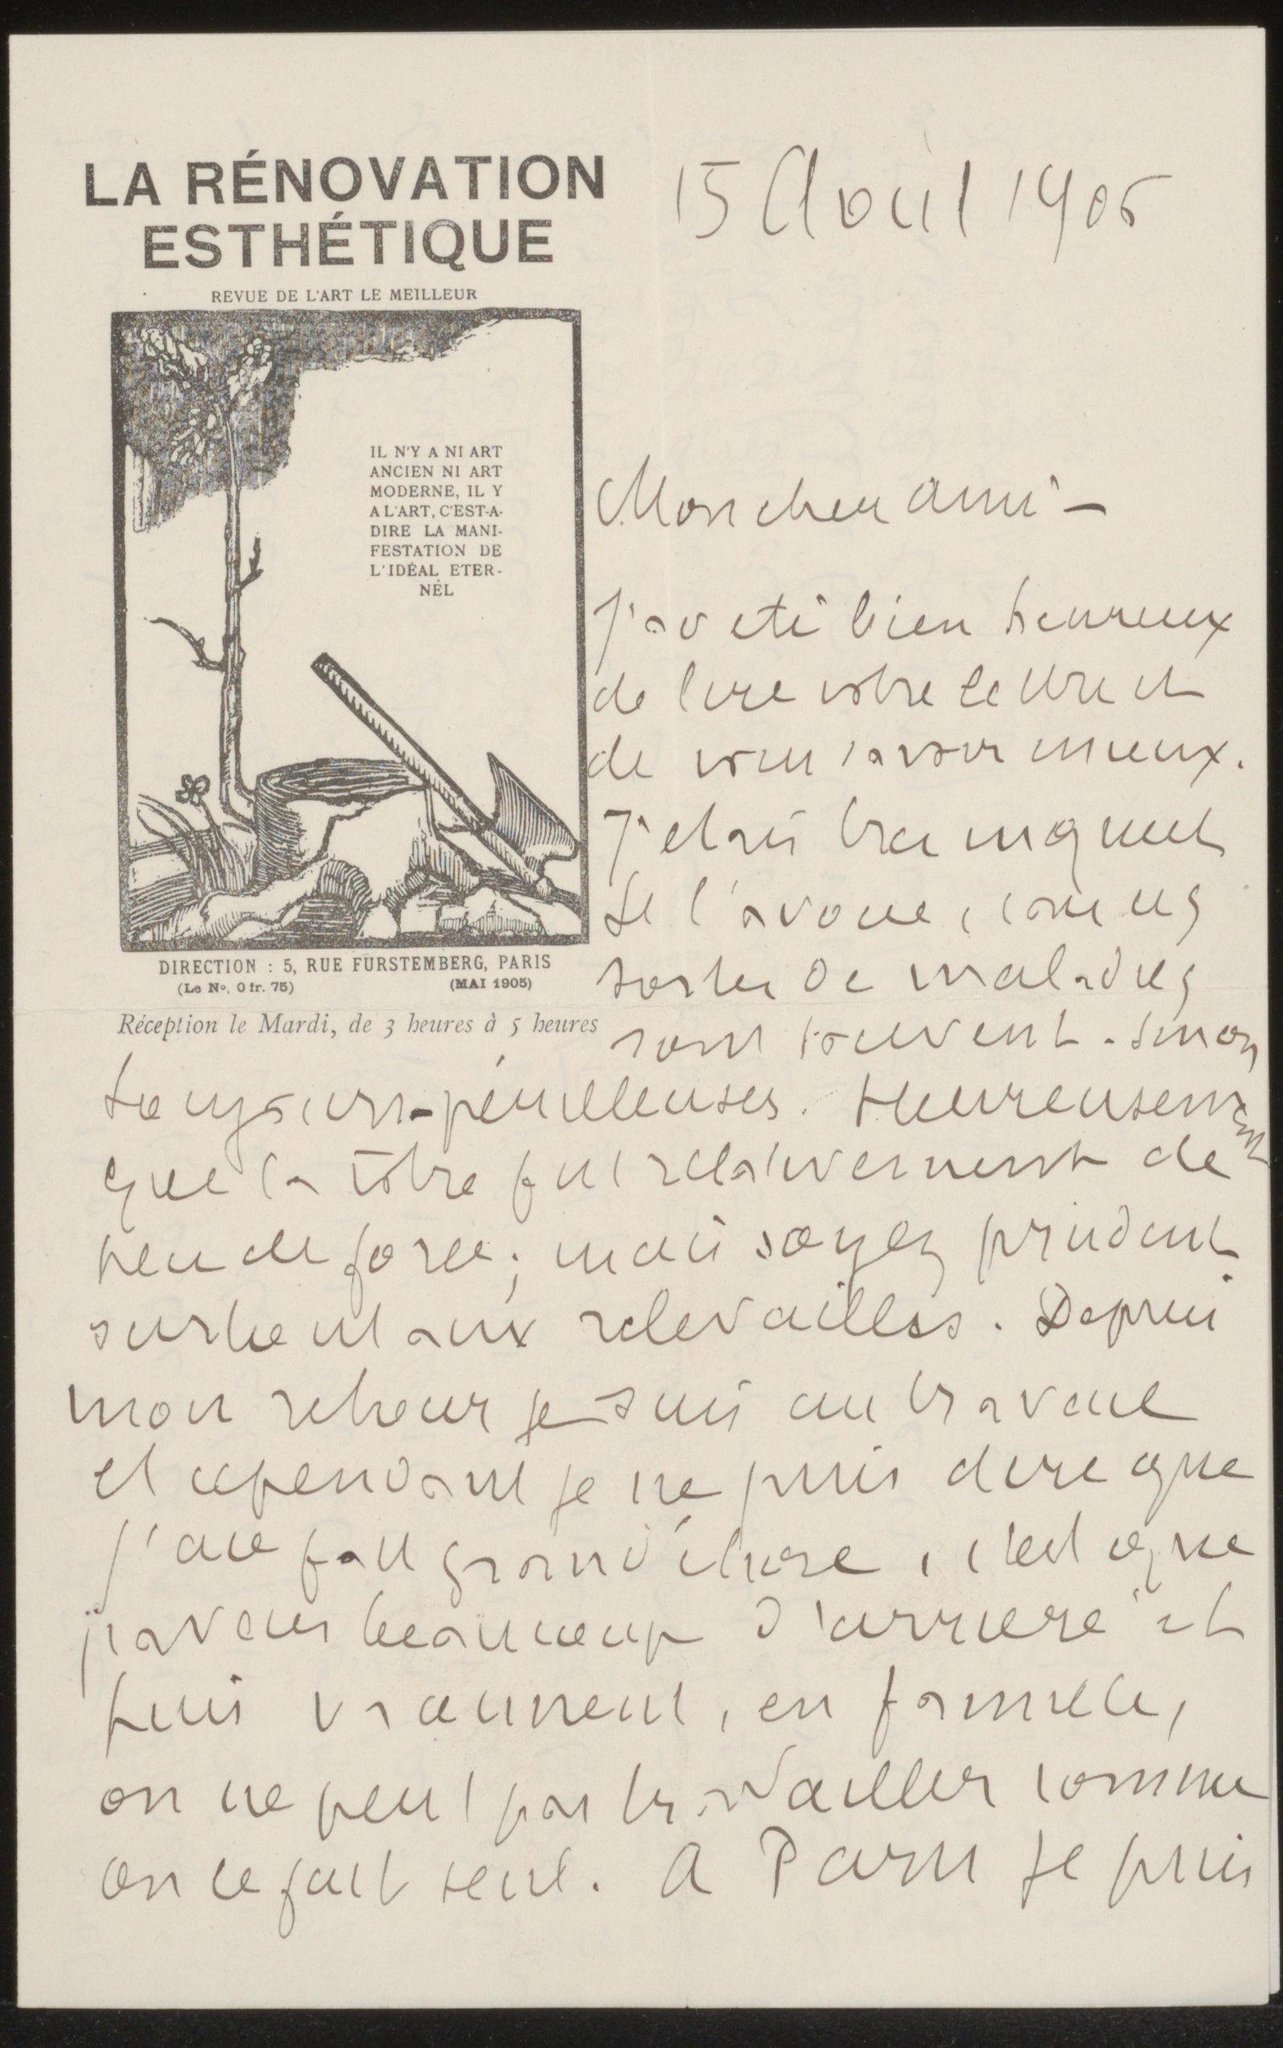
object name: letter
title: Brief aan Andries Bonger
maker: émile bernard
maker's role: print maker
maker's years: 1868-1941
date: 1906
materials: ink, paper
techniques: pen, printing, writing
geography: tonnerre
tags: amsterdam, andries bonger, applied arts, arts and crafts; industrial design, family life, painting (including book-illumination, miniature-painting)